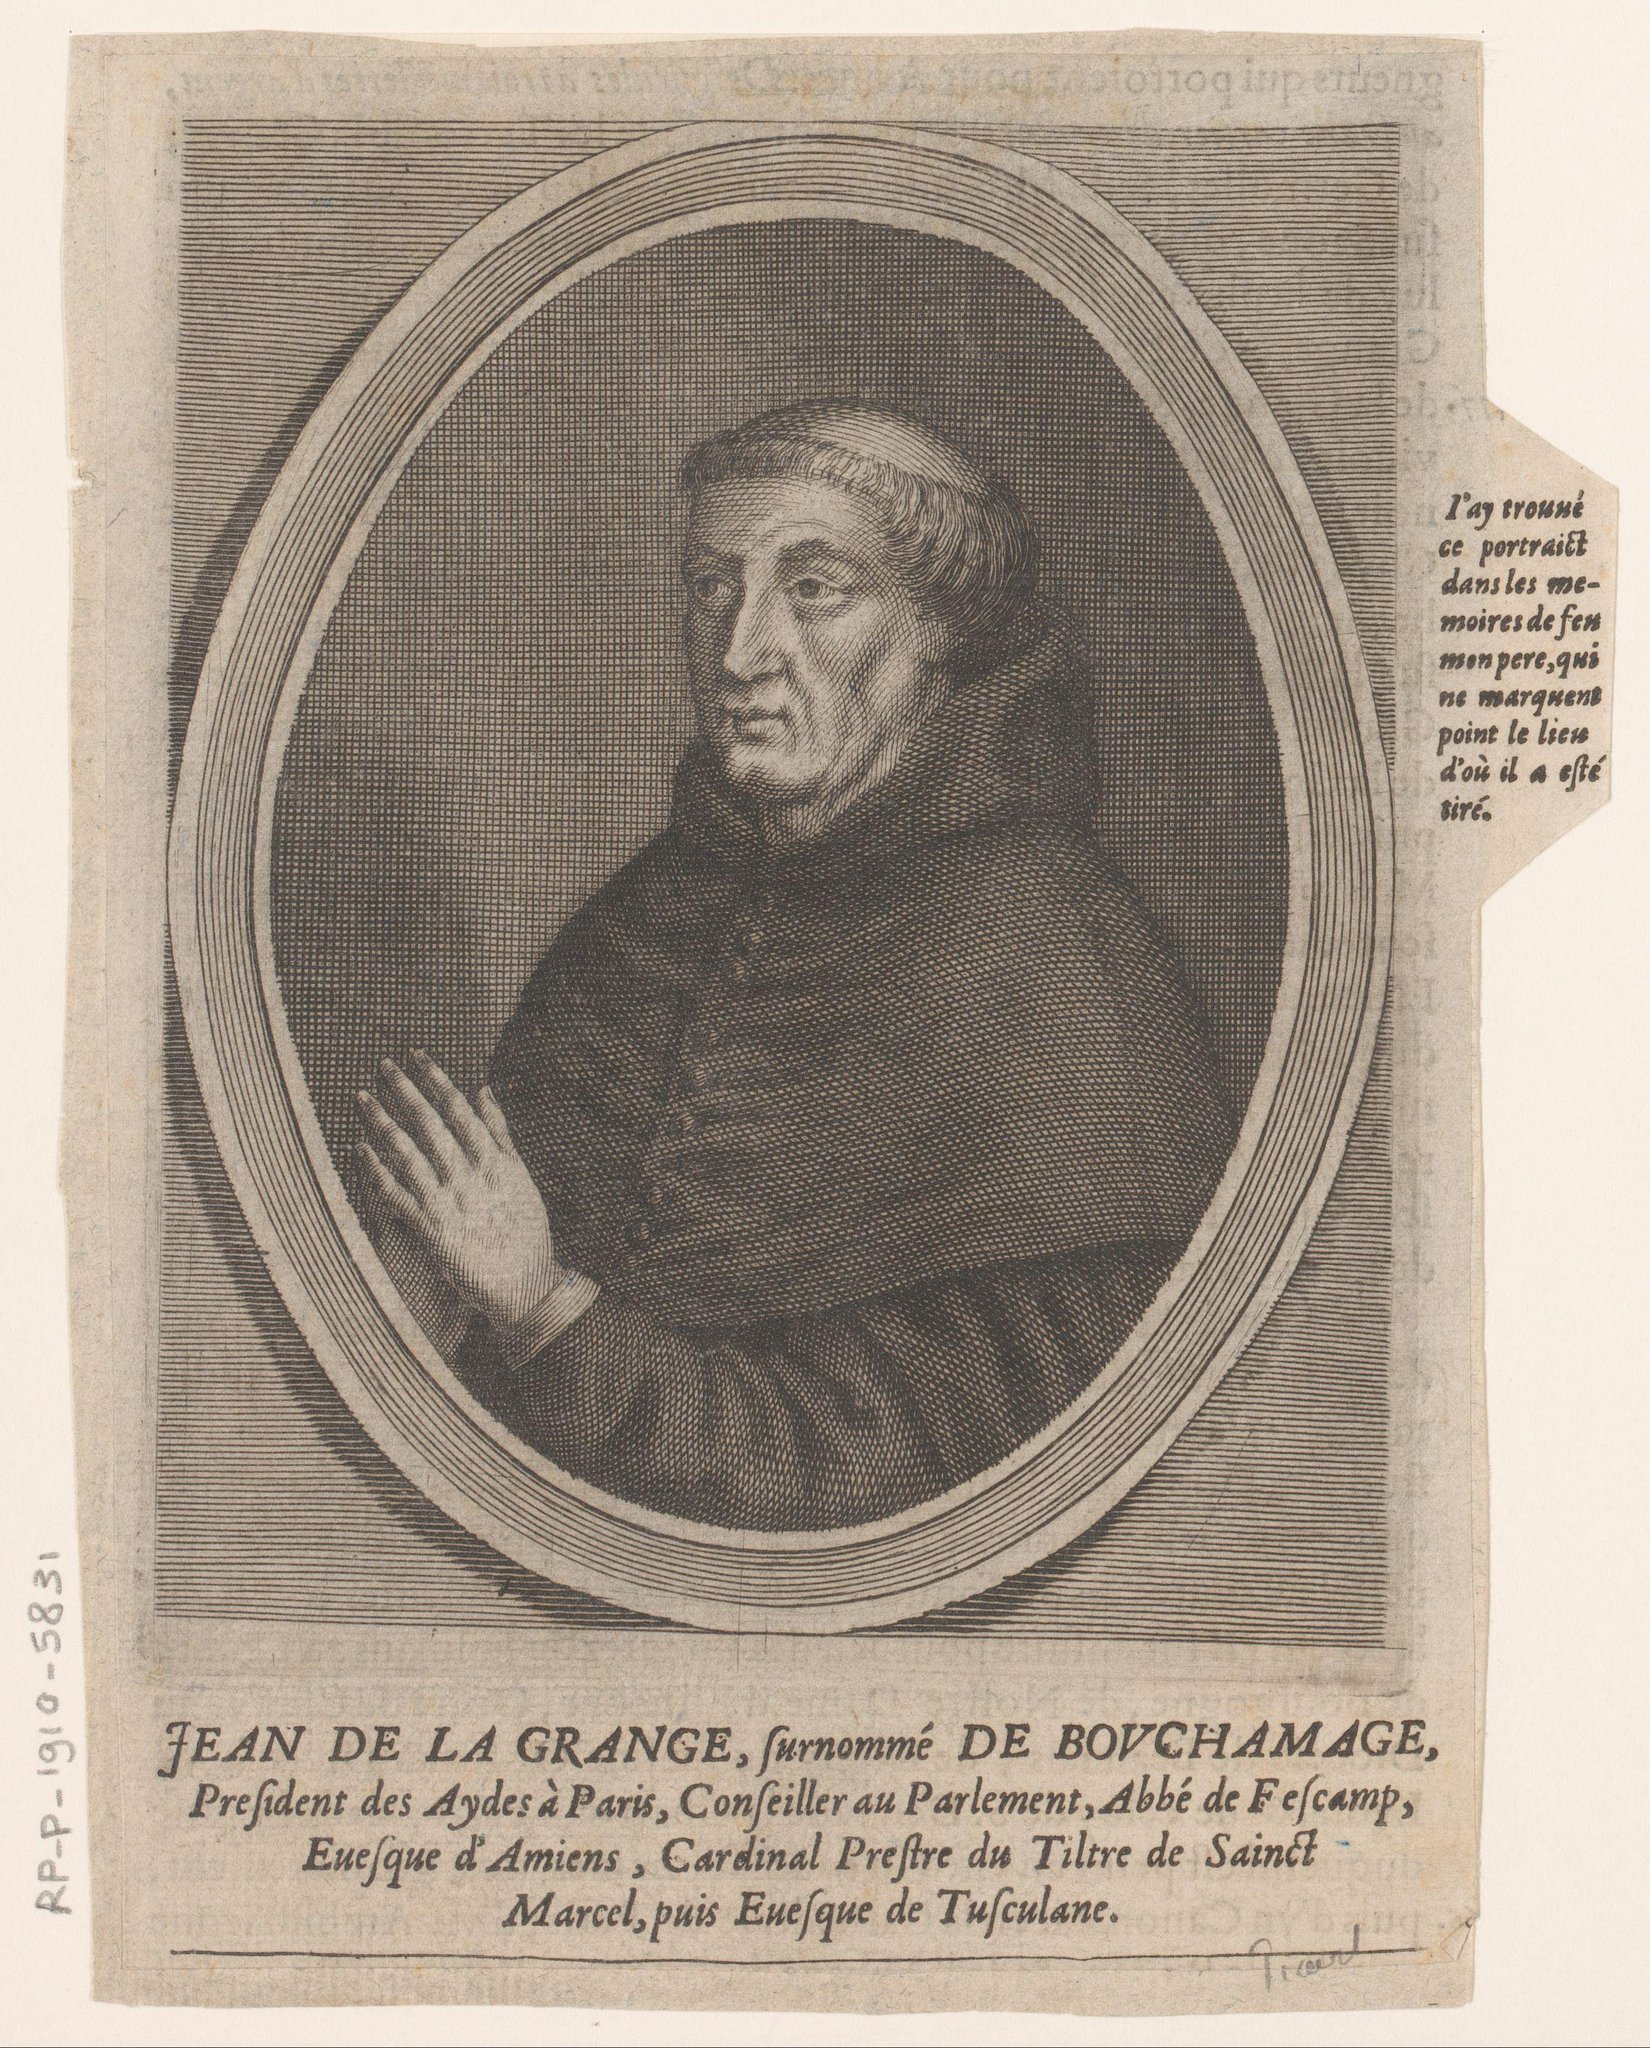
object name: book illustration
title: Portret van Jean de La Grange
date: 1660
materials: paper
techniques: engraving, etching, letterpress printing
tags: archbishop, bishop, etc. (roman catholic), historical persons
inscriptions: collector's mark: Lugt 2228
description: Prent uit: Du Chesne, François. Histoire de tous les cardinaux françois de naissance, ou qui ont esté promeus au cardinalat. Parijs: François Du Chesne, 1660.